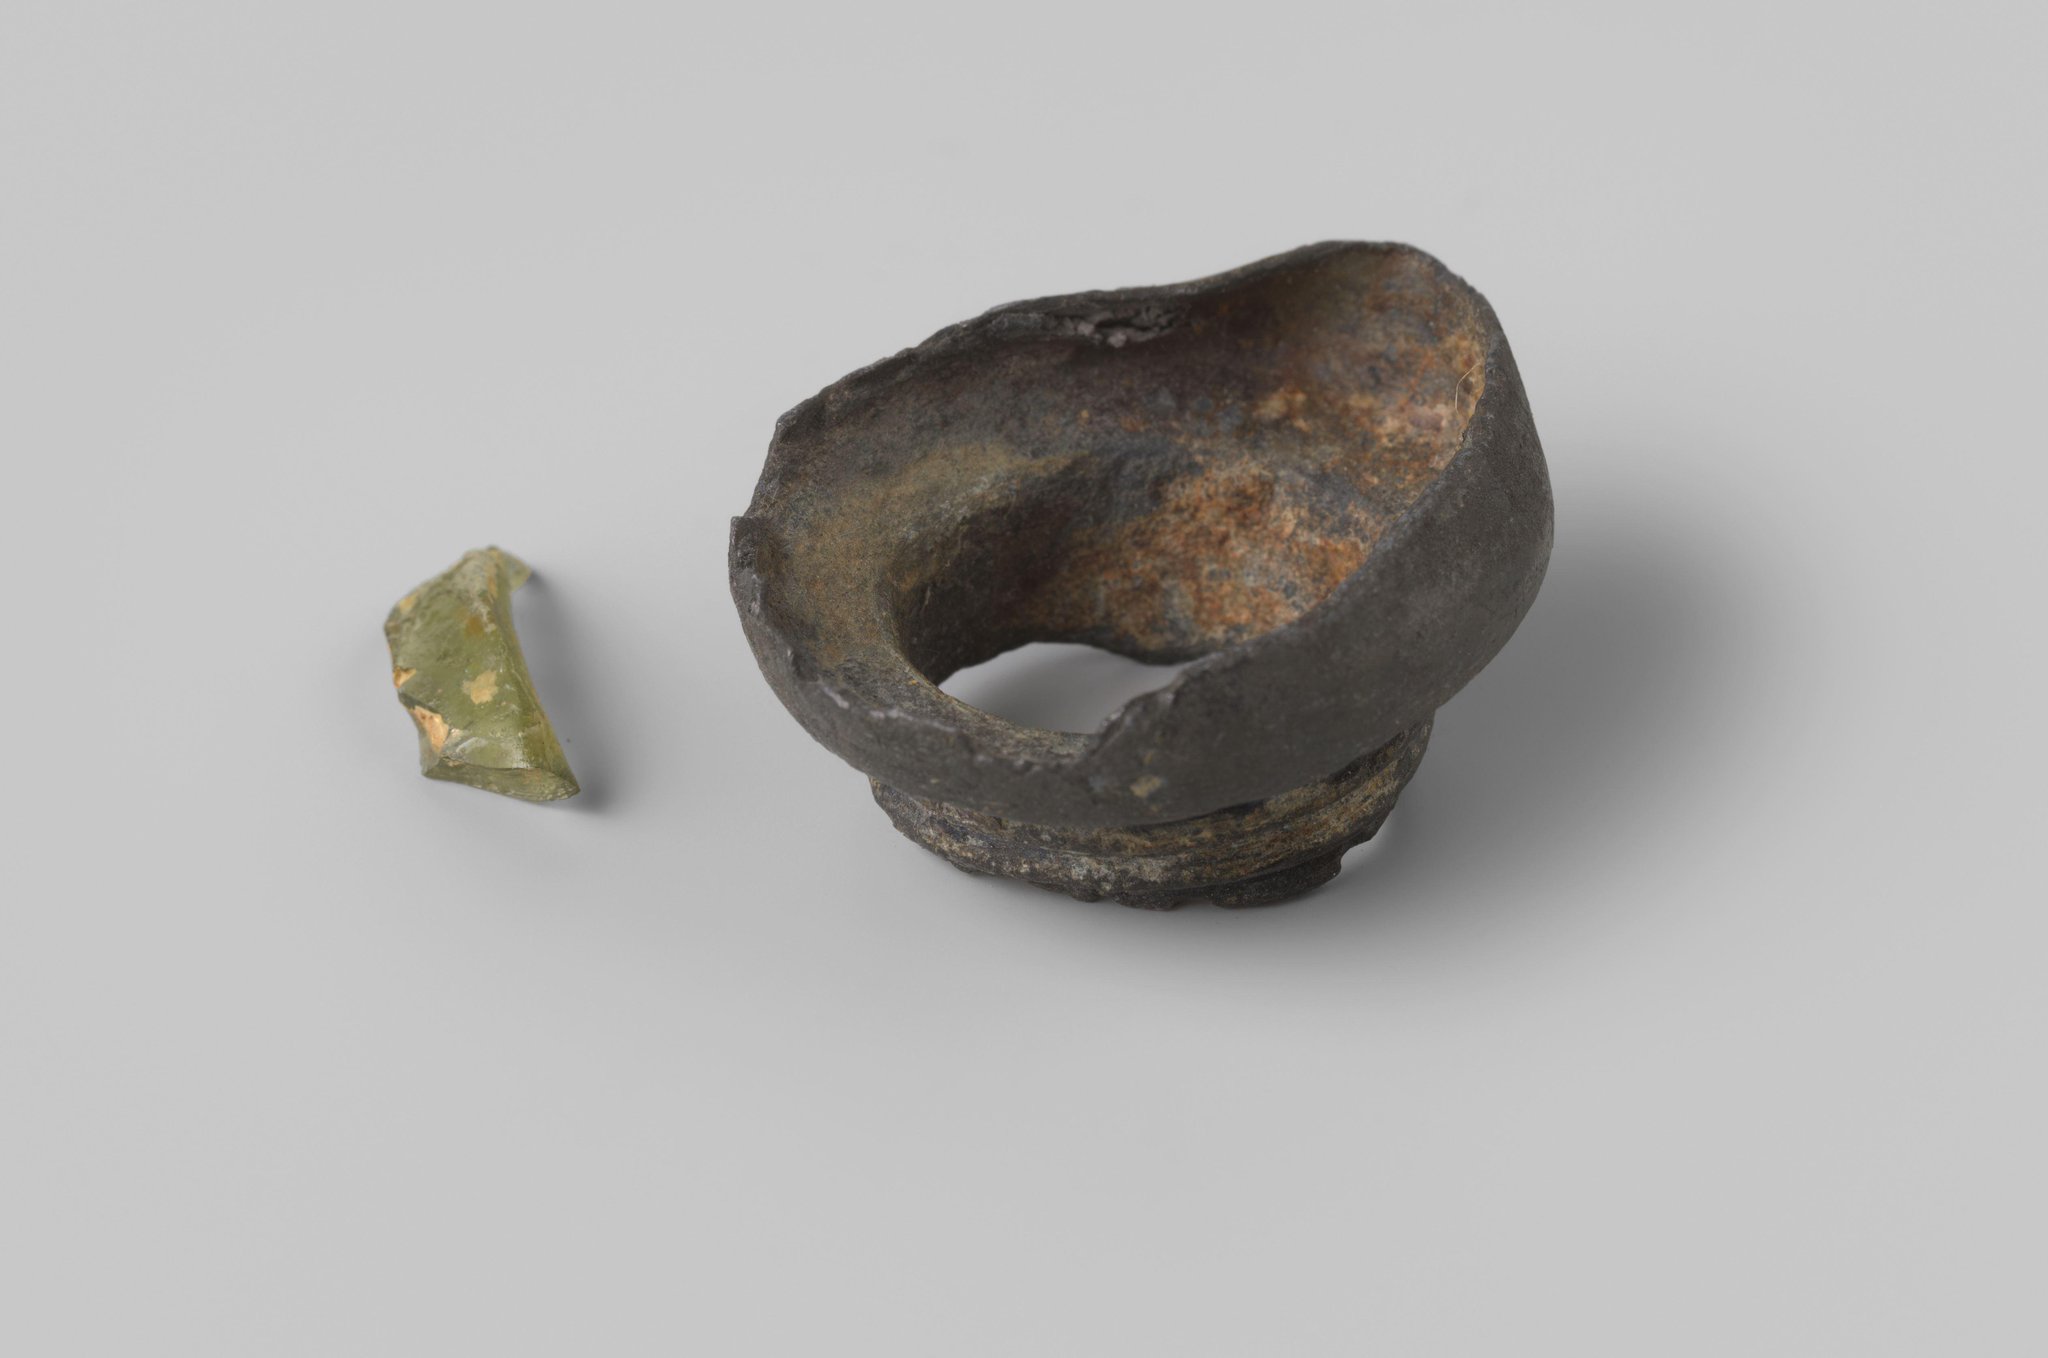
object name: screw in socket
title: Schroeffitting en glasscherf uit het wrak van de Oost-Indiëvaarder Hollandia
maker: Anonymous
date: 1700-1743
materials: glass, tin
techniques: green glass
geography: netherlands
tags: verenigde oostindische compagnie, hollandia (schip), annet